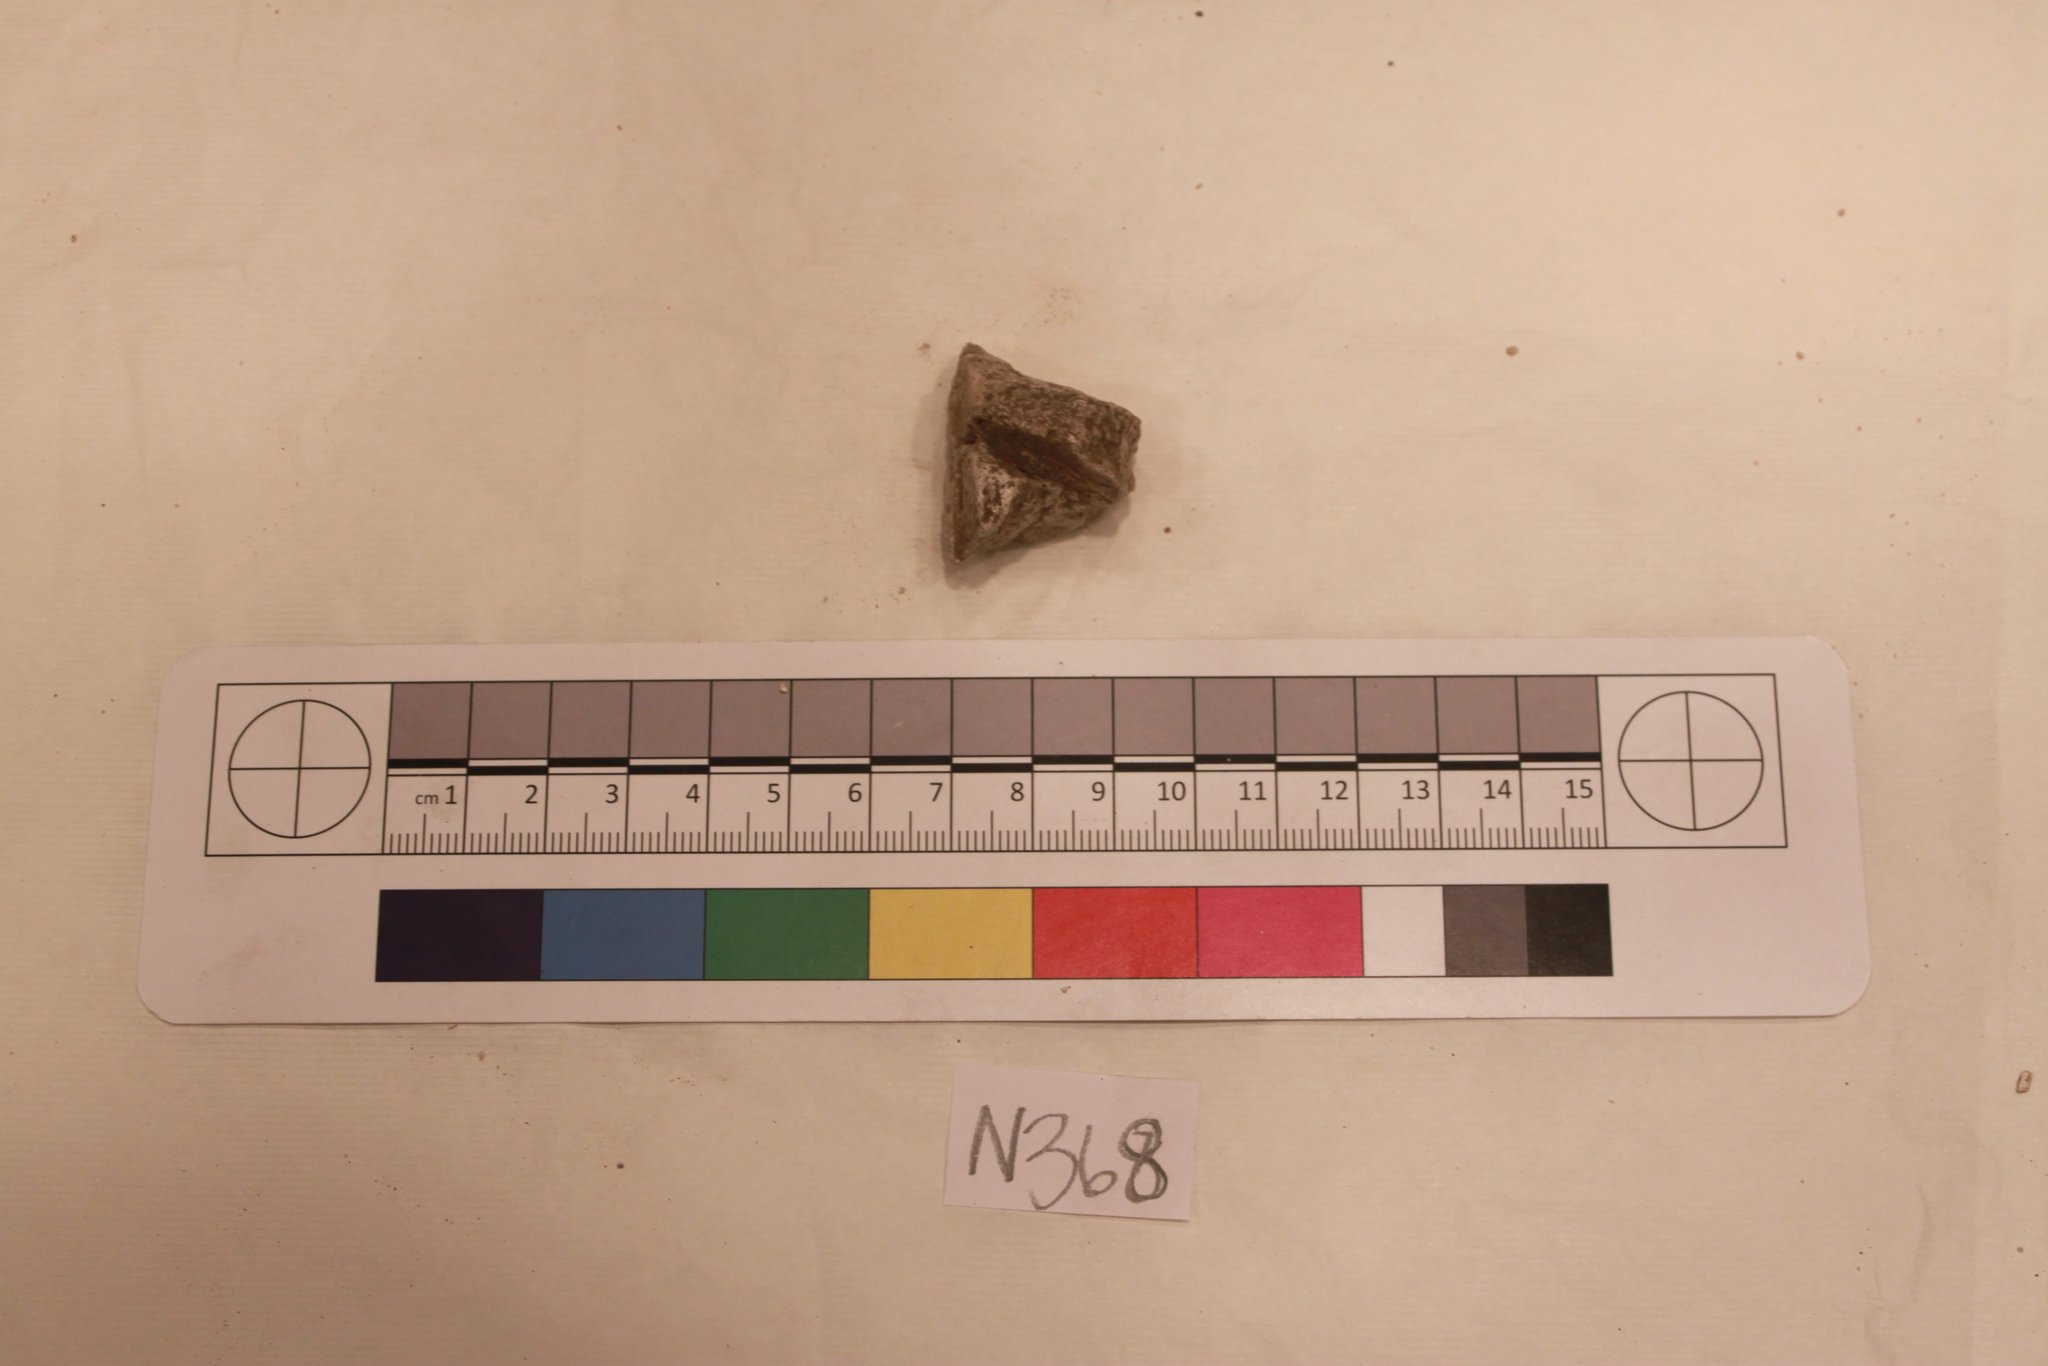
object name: fragment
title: Stucco Fragment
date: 701-1200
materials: plaster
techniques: carving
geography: iran